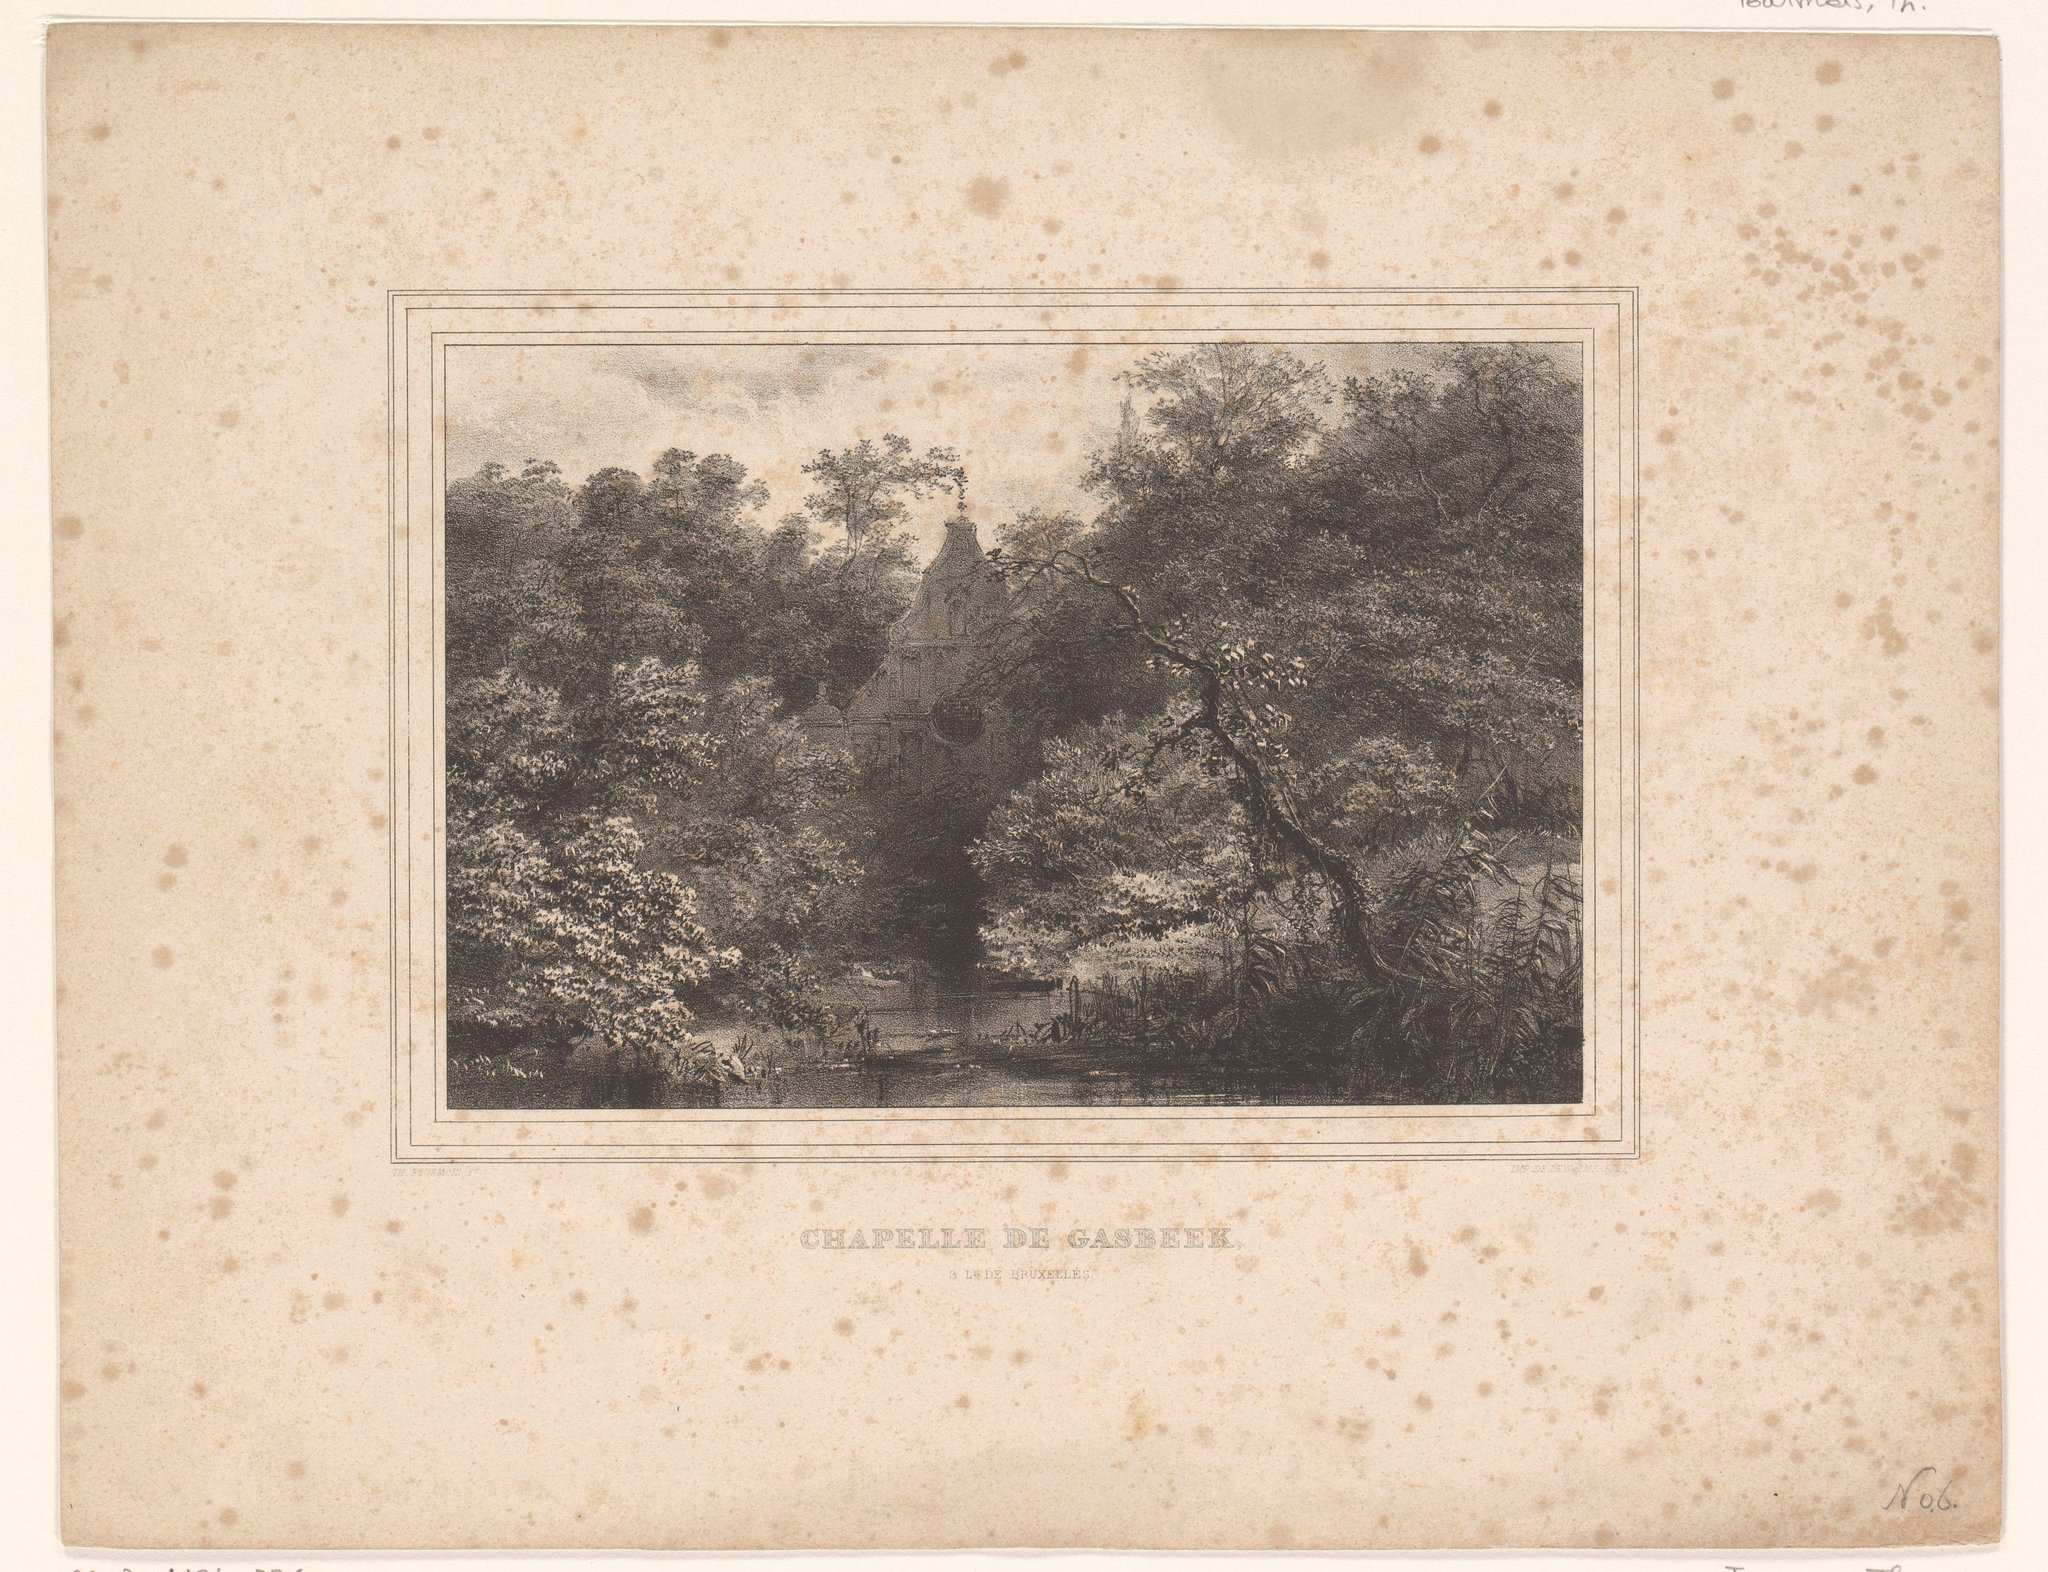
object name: print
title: Gezichten op de omgeving van Brussel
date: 1825-1827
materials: paper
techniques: lithograph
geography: brussels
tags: parts of church exterior and annexes: chapel, landscapes with waters, waterscapes, seascapes (in the temperate zone)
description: Prent maakt waarschijnlijk deel uit van een serie met gezichten op de omgeving van Brussel. Over deze serie is verder niets bekend. Het betreft voornamelijk landschappen en gebouwen.